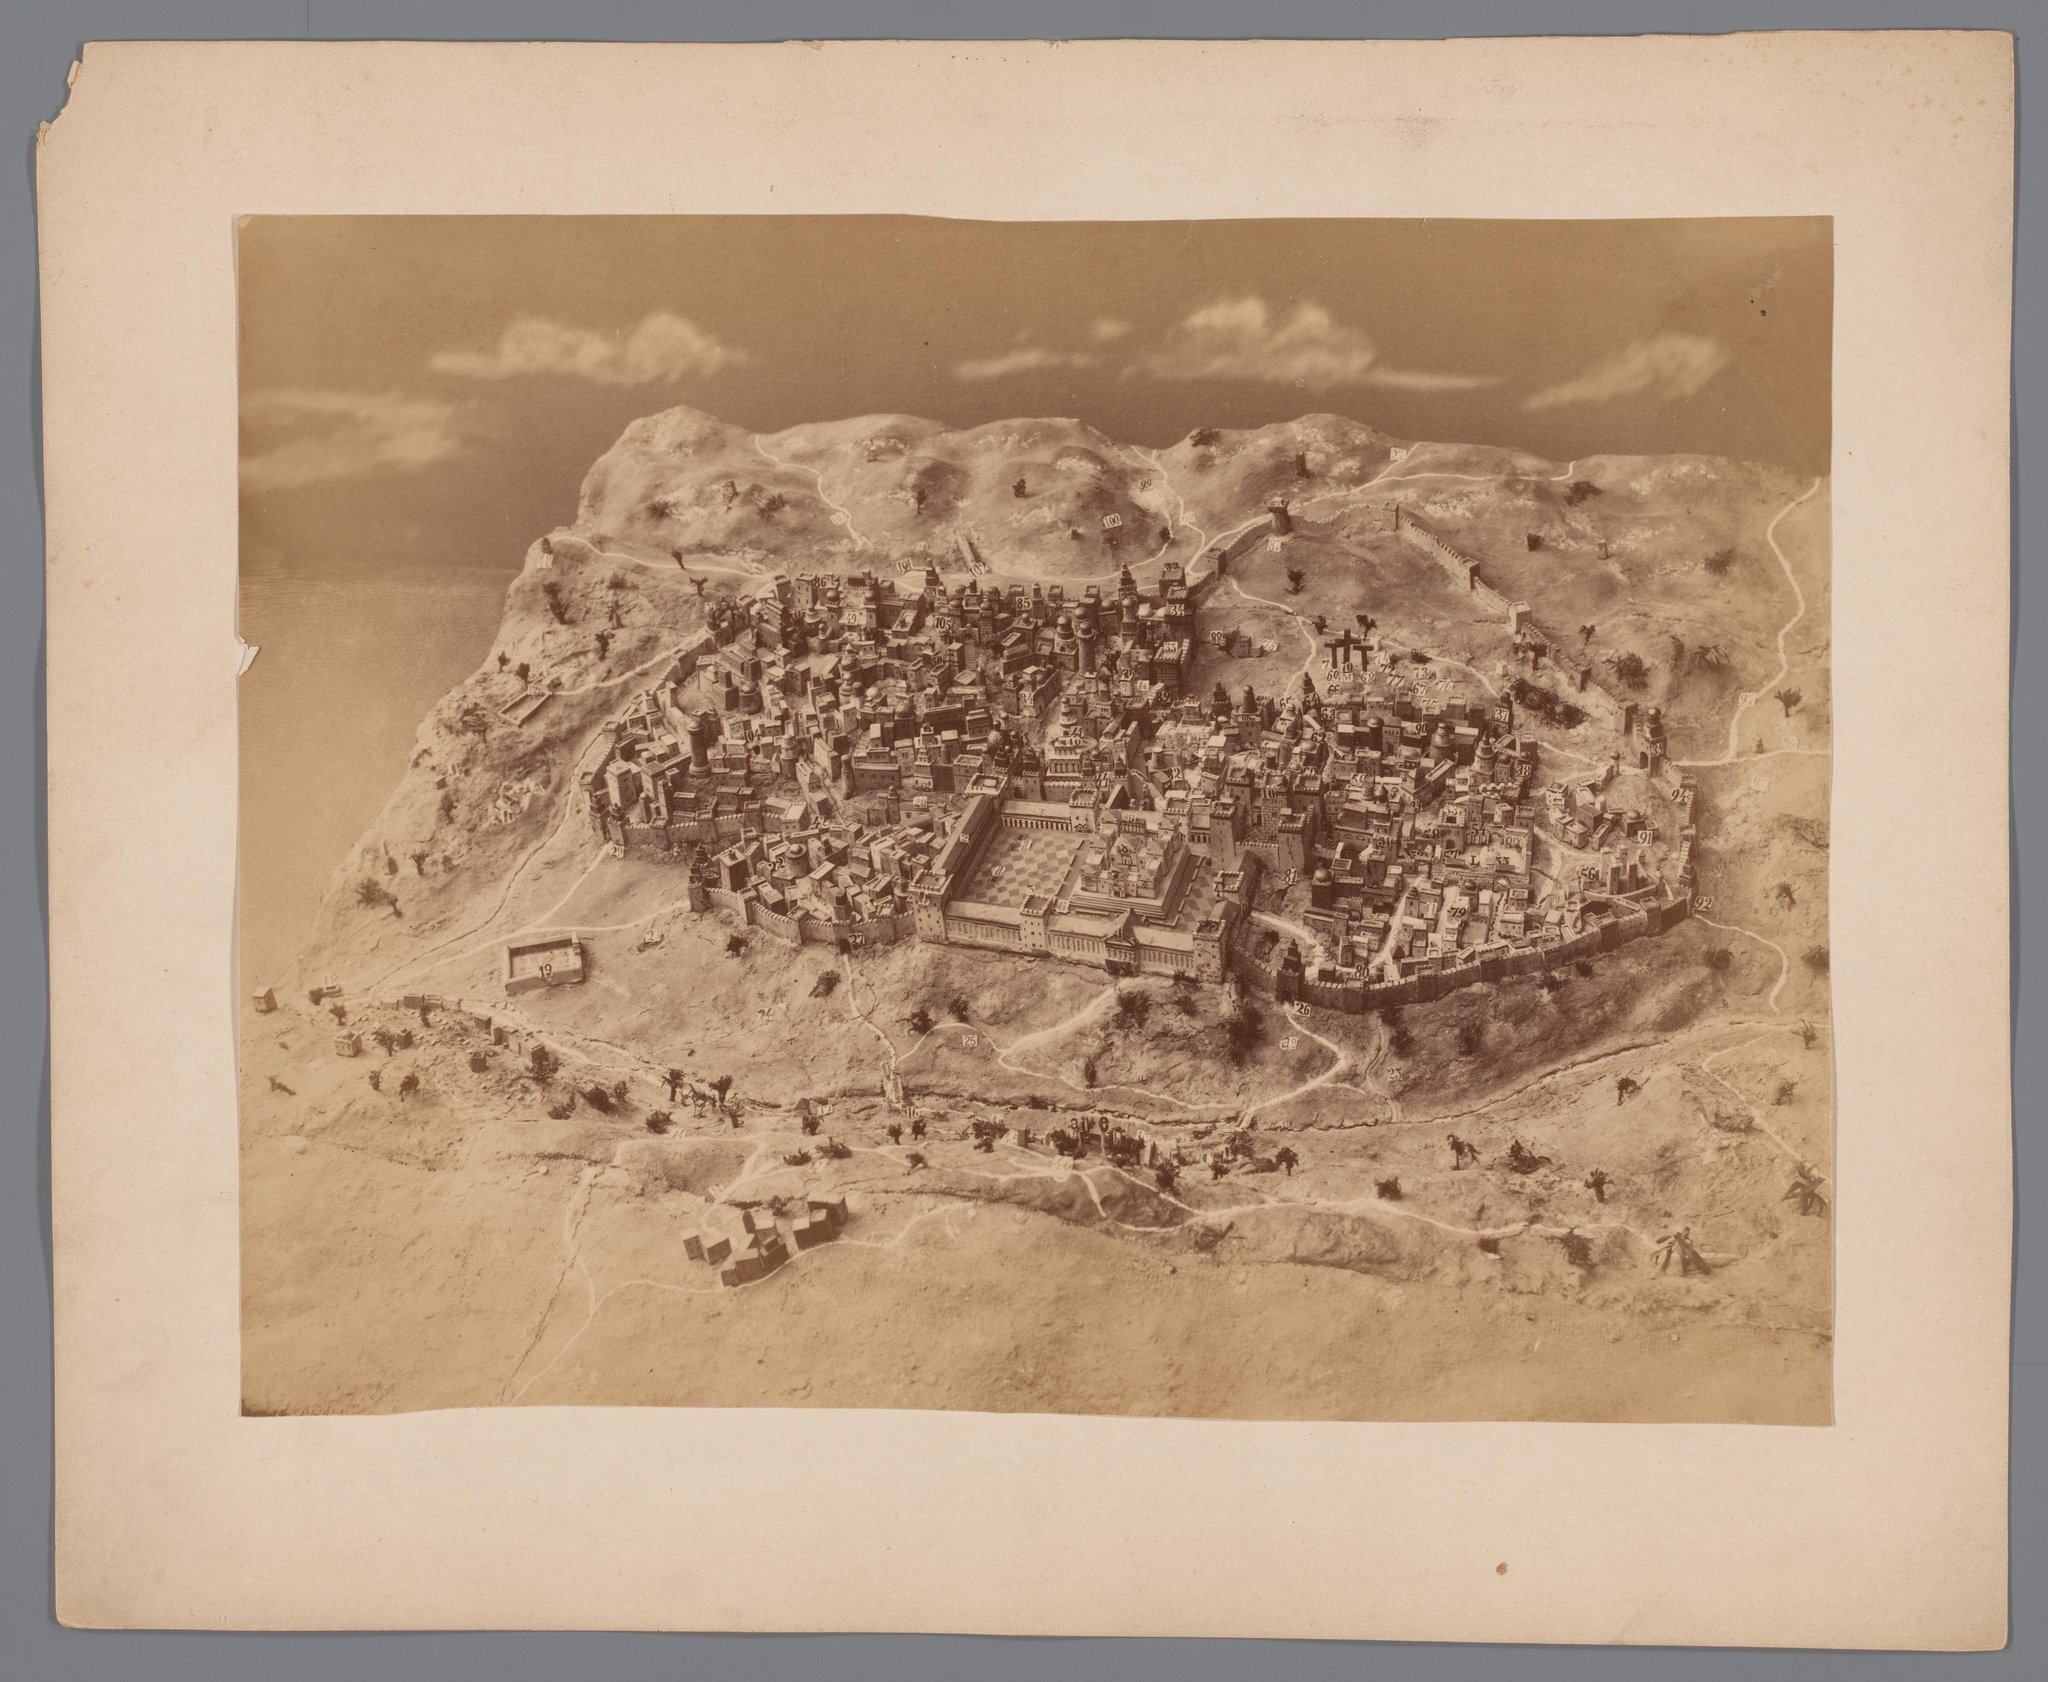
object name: photograph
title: Maquette van Jeruzalem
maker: Anonymous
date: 1875-1910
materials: cardboard, paper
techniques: albumen print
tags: jeruzalem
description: Luchtfoto van model op schaal van een Oosterse [?] ommuurde stad [?]. Een groot ommuurd (paleizen)complex met daaromheen kleinere huizen. Er staan bij alle gebouwen nummers afgebeeld, die vermoedelijk verwijzen naar de uitleg bij de afgebeelde gebouwen elders.